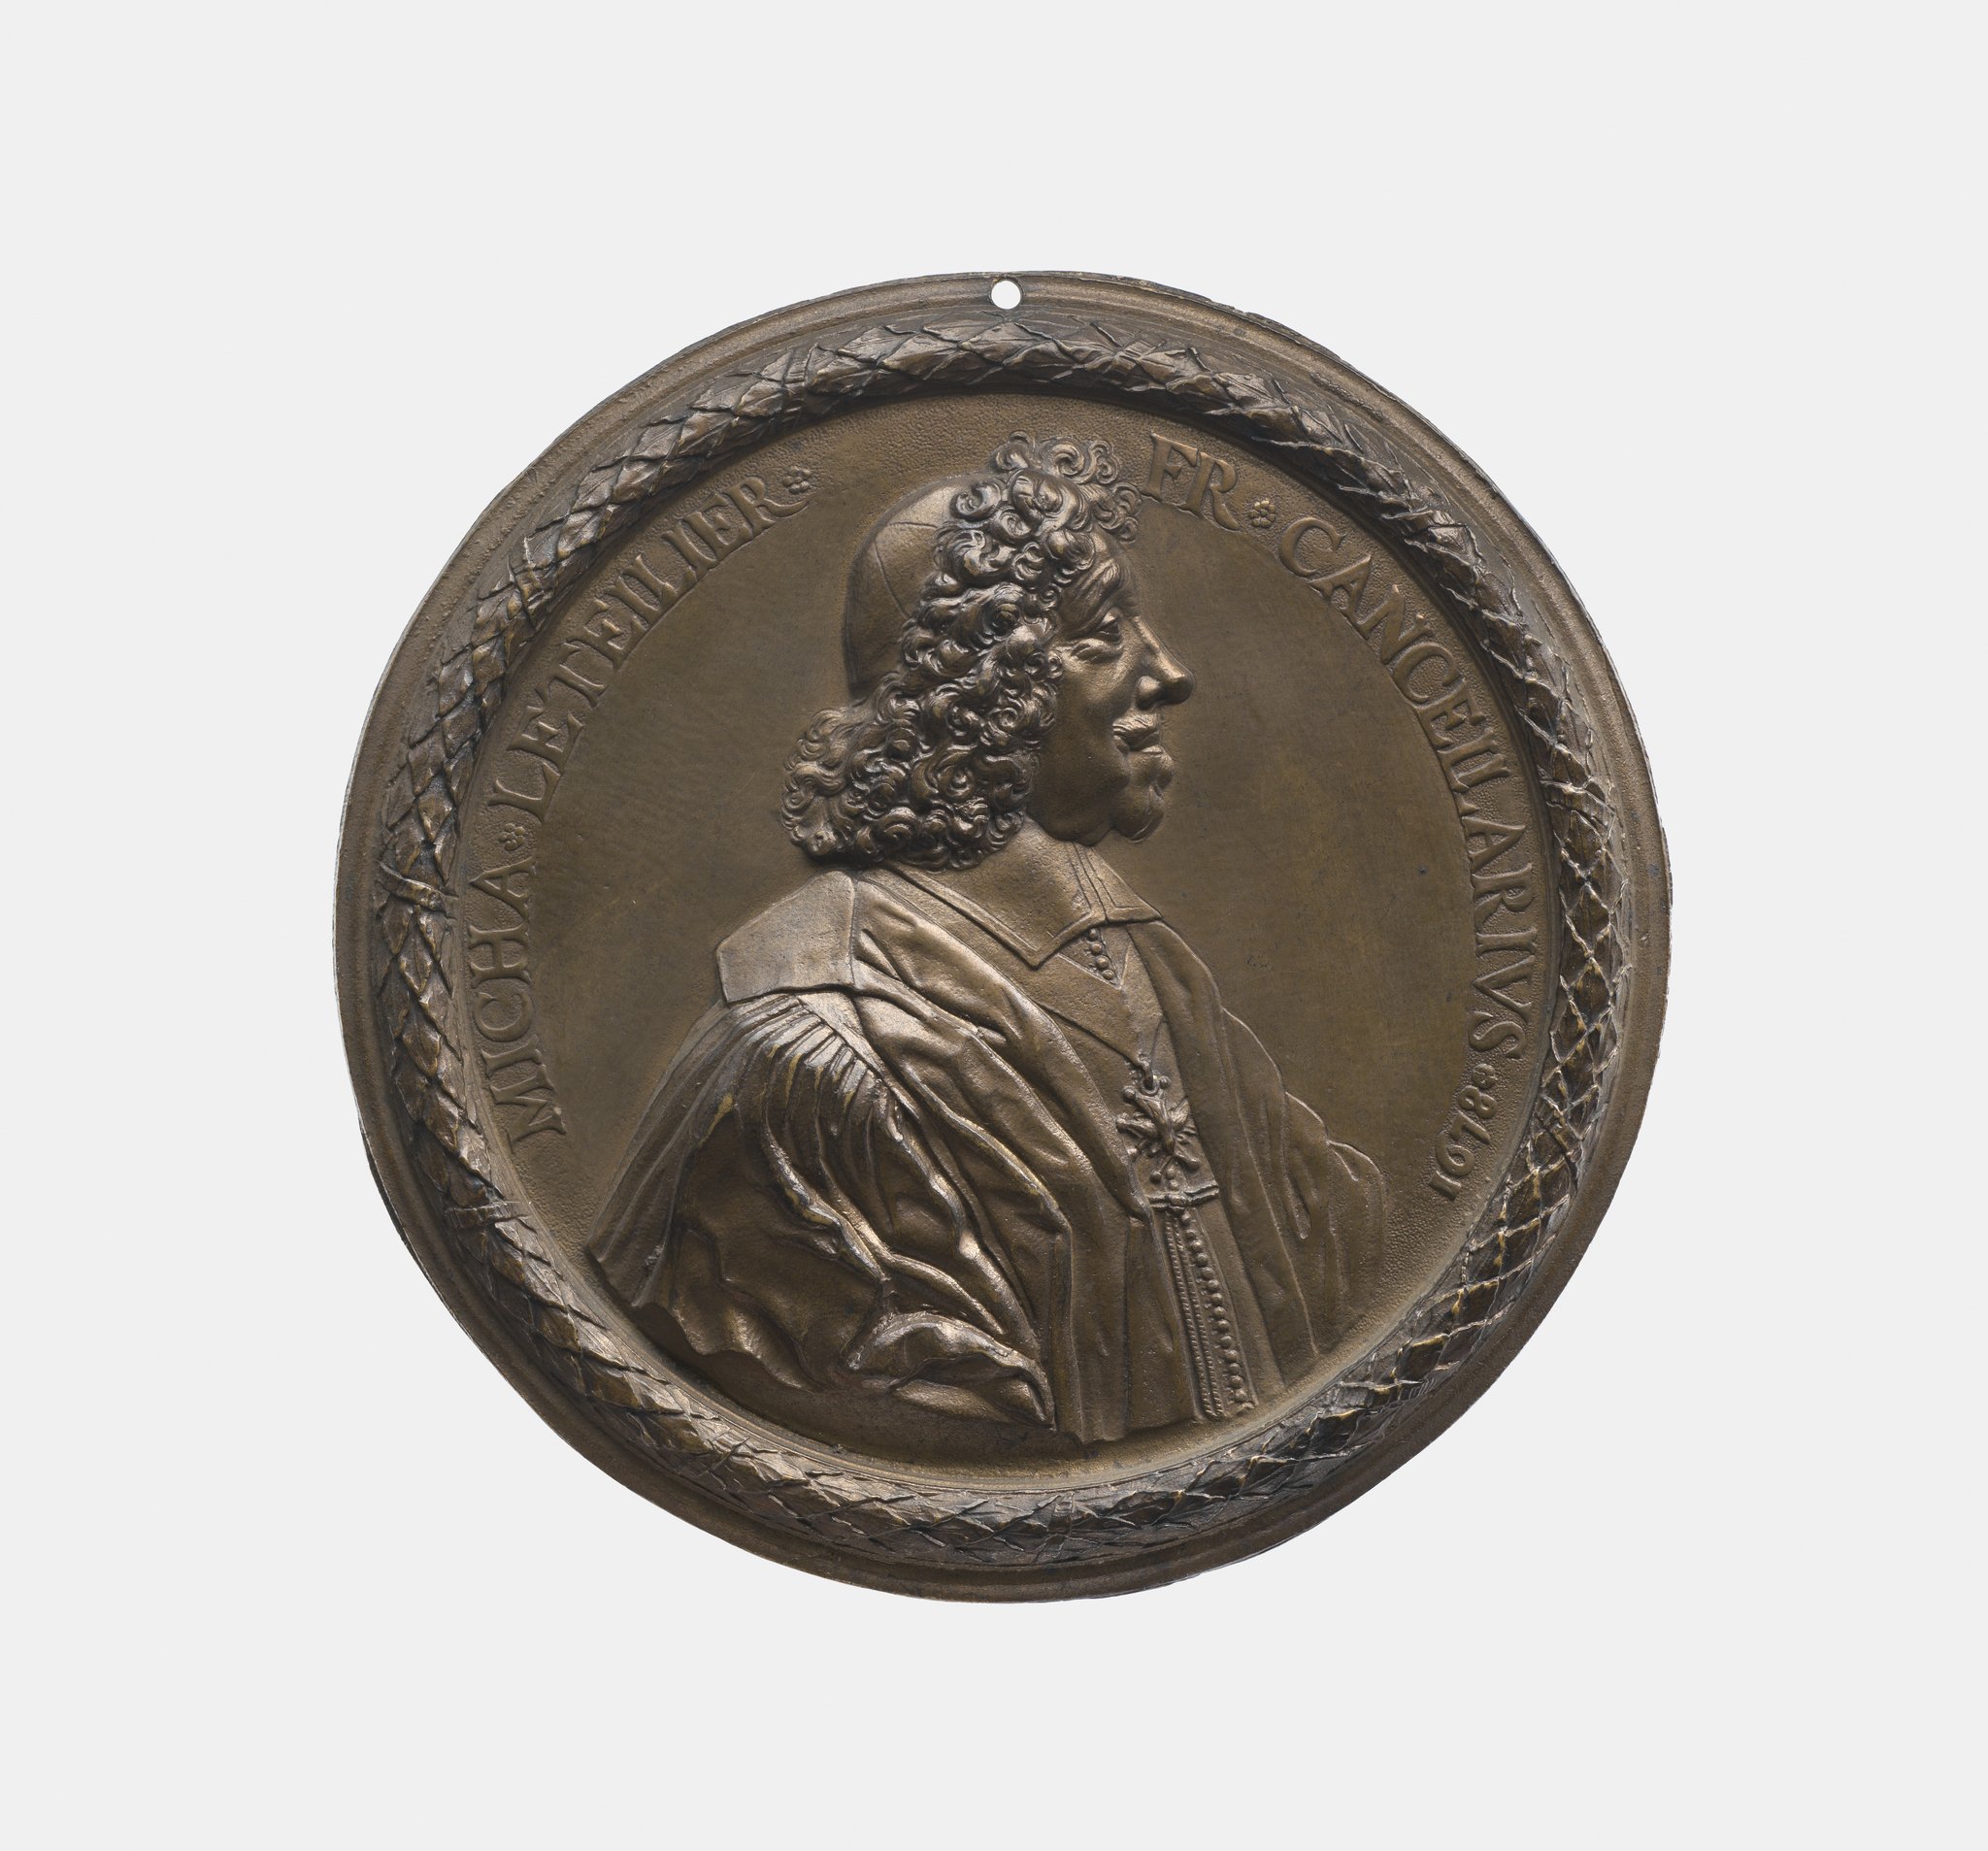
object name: medal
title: Michel Le Tellier 1603-85, French statesman, Minister under Louis XIV and Mazarin, later Chancellor of France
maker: françois bertinet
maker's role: artist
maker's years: 1600-1711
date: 1678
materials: bronze